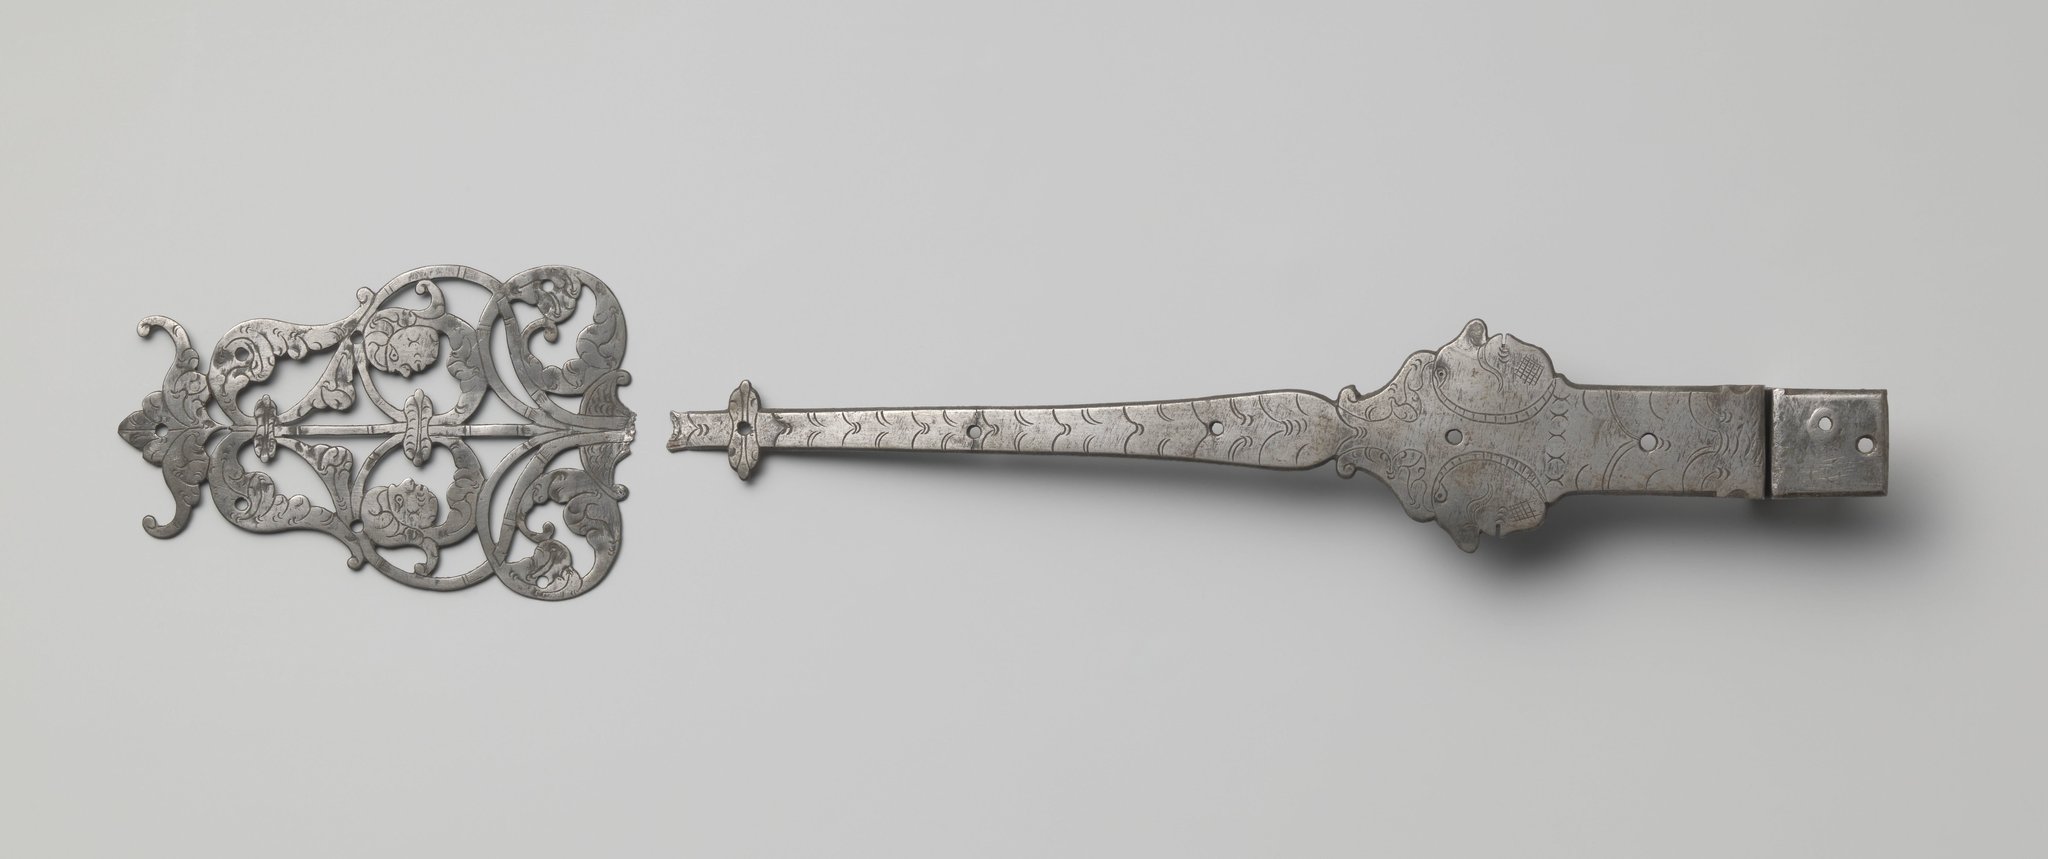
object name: deurhengsel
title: Deurhengsel van vertind ijzer, versierd met graveringen en narrenkoppen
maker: Anonymous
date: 1600-1700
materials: iron, tin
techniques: metalworking, engraving, tinning